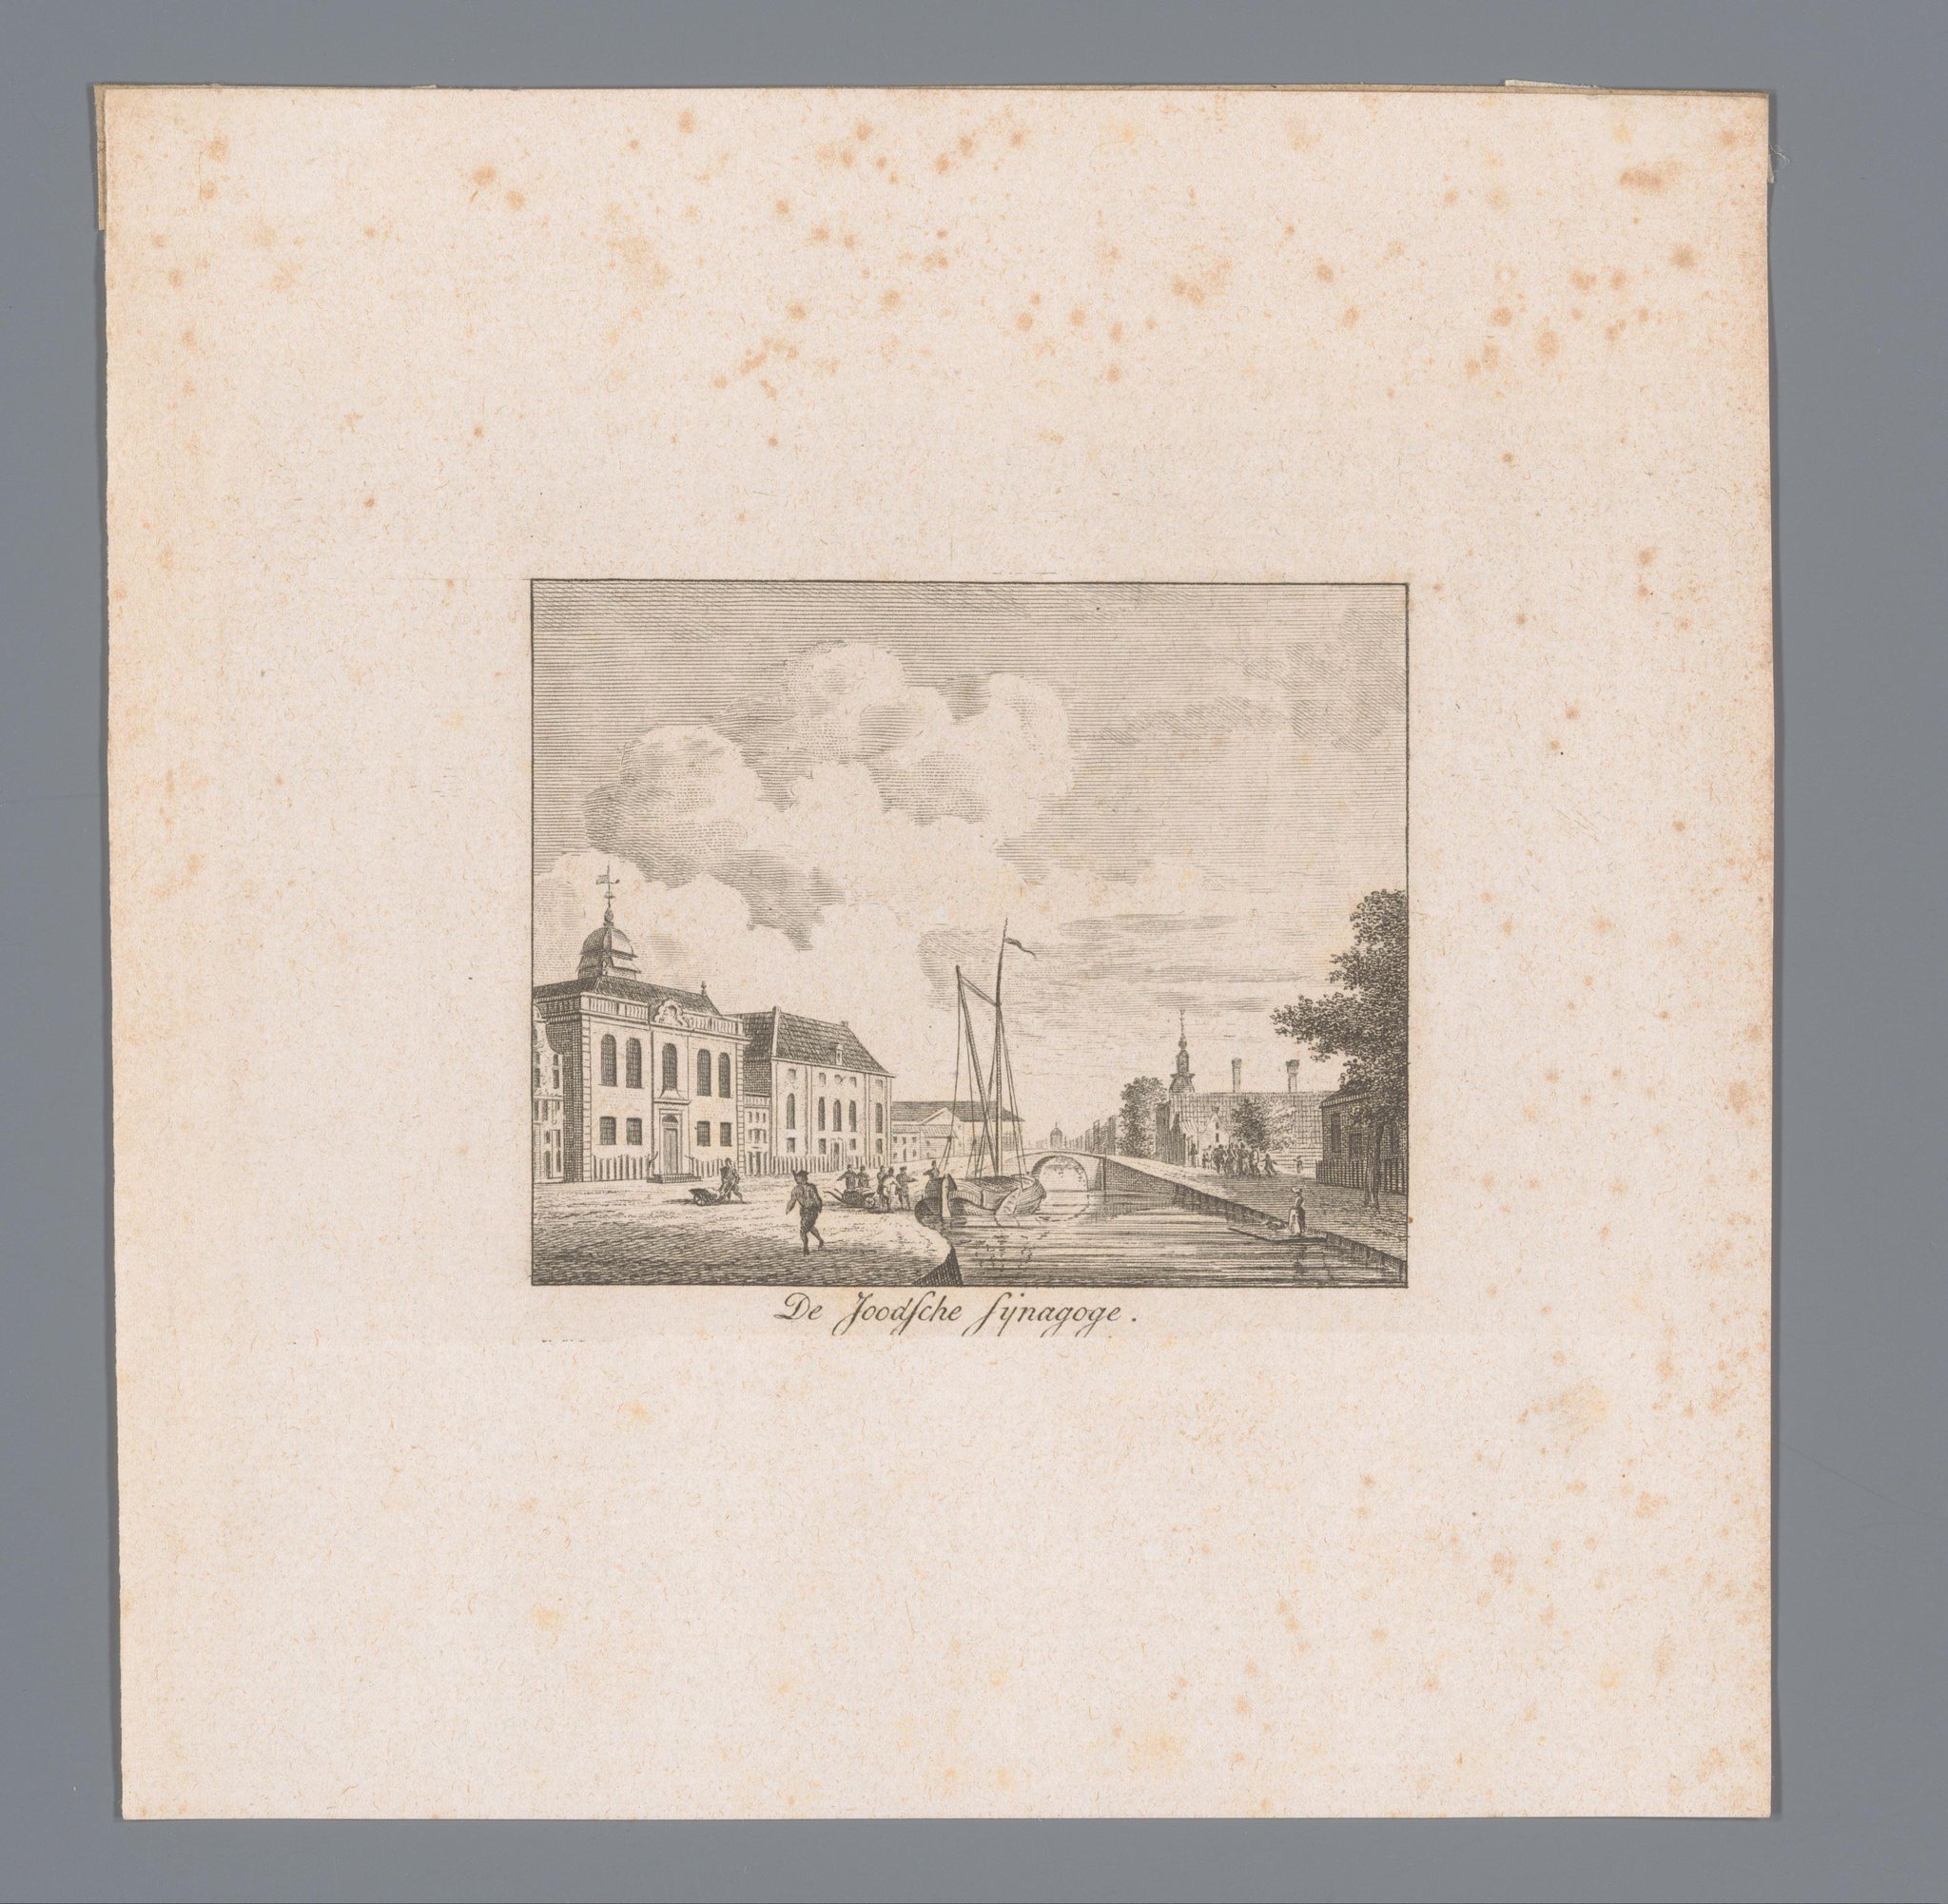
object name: print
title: De Joodsche Synagoge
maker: hendrik keun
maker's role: painter, print maker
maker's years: 1738-1787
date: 1770-1794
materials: paper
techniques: etching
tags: the synagogue (as building and place of worship ~ jewish religion)